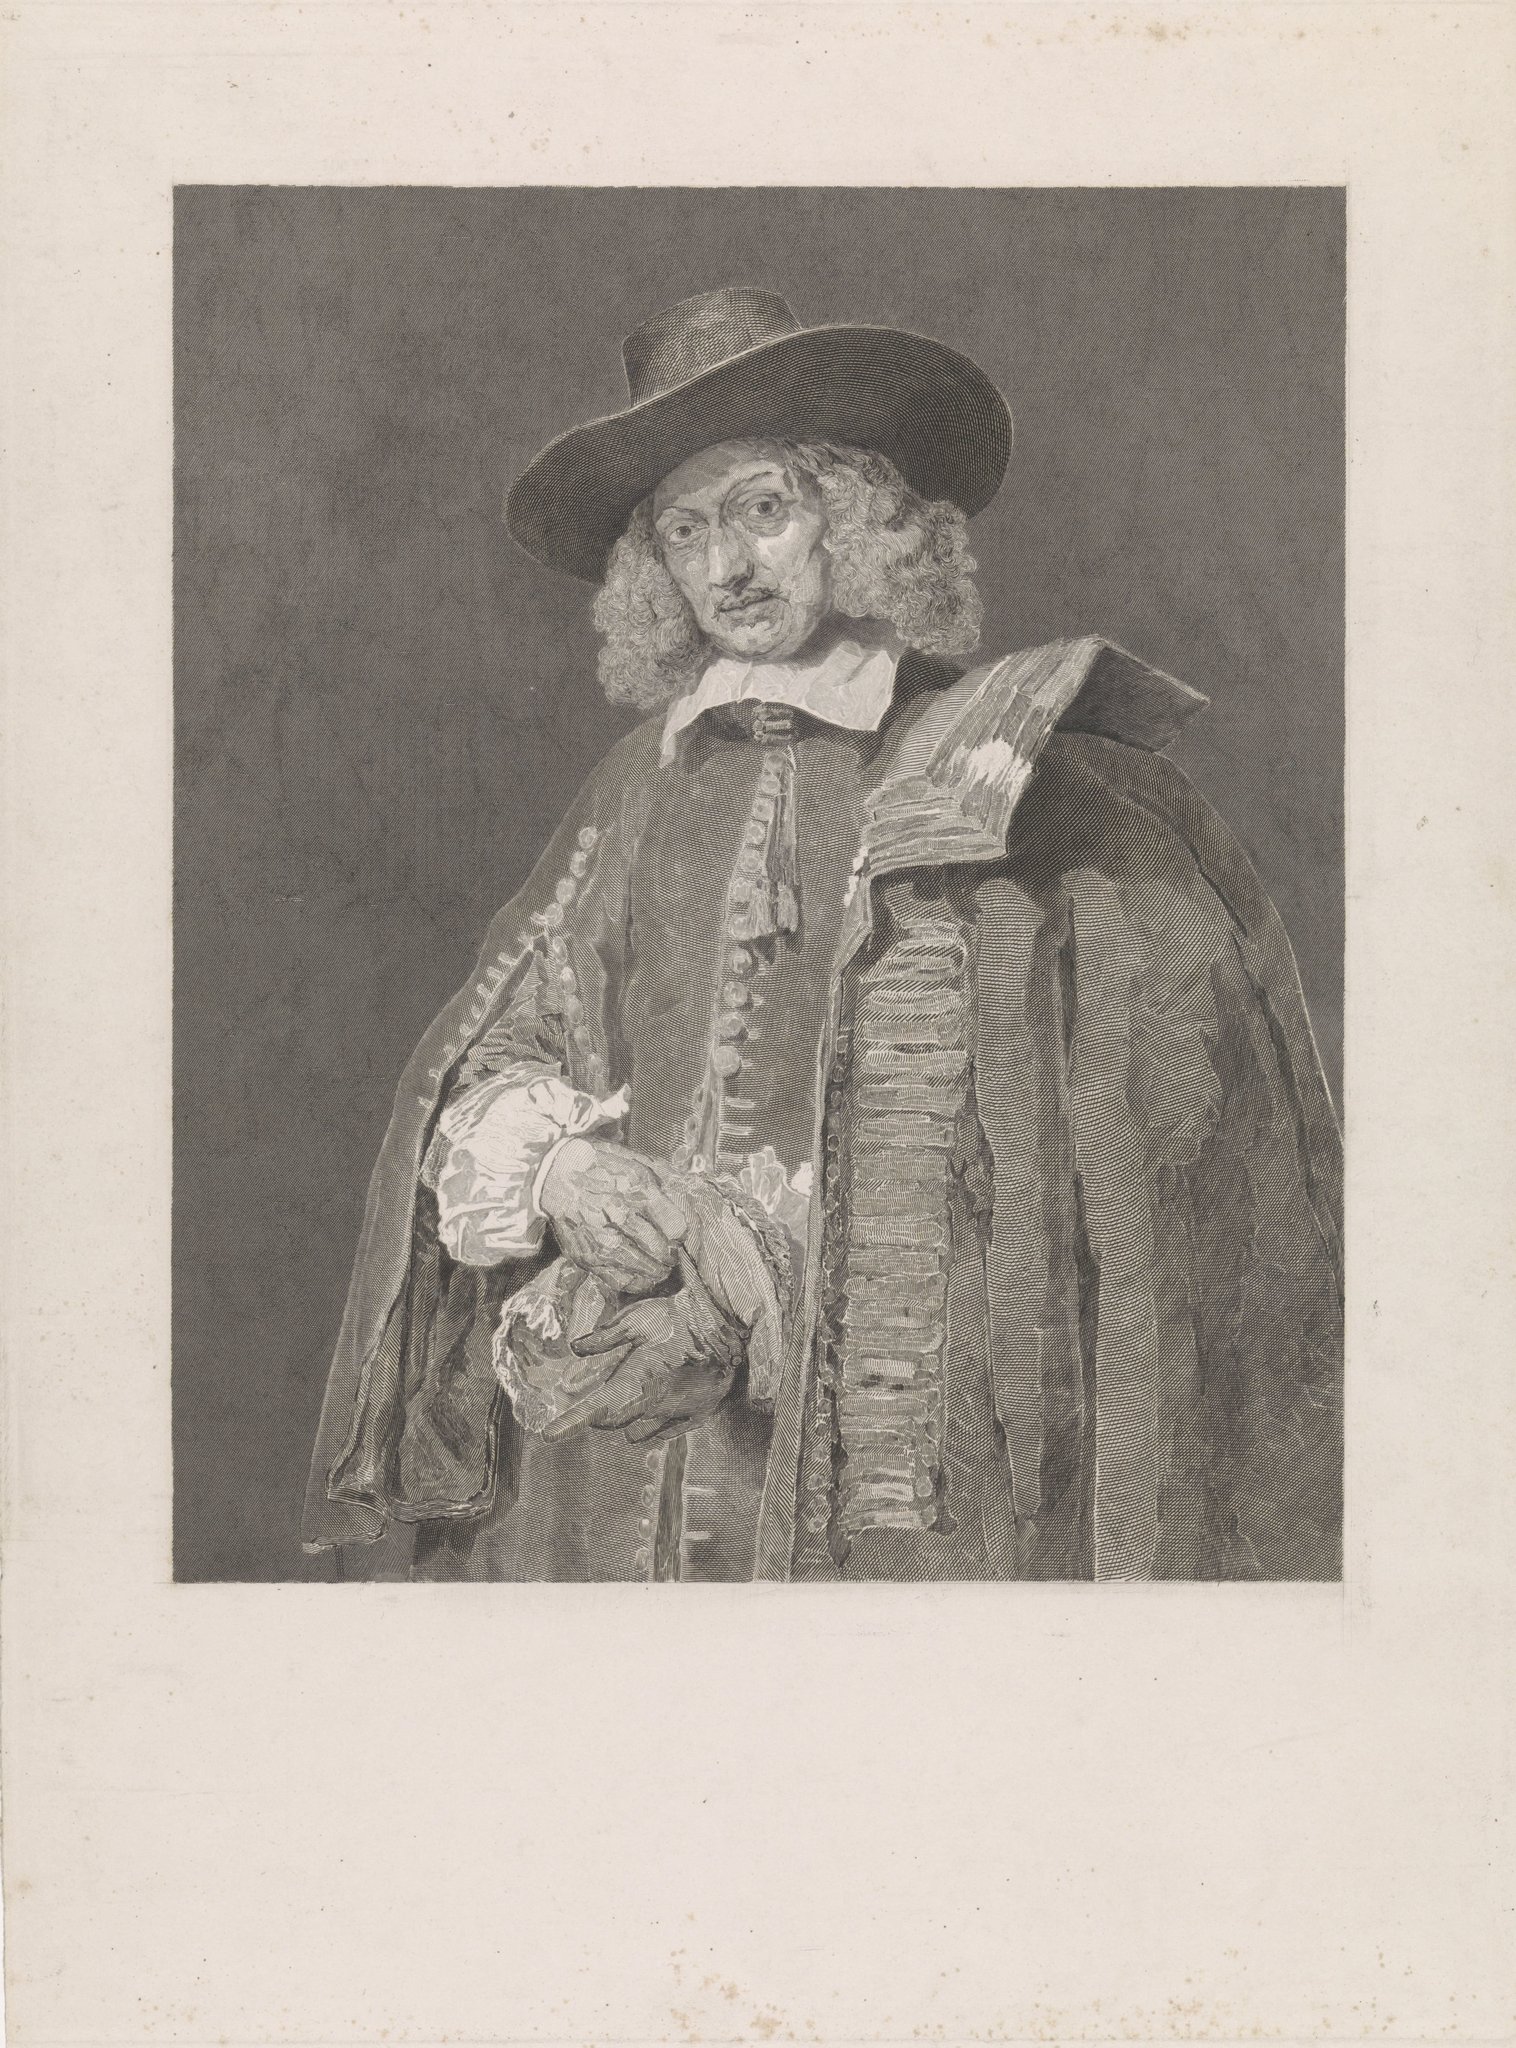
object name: print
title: Portret van Jan Six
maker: johann wilhelm kaiser (i)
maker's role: draughtsman, print maker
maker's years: 1813-1900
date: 1823-1853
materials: paper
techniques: etching, roulette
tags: amsterdam, mayor, jan six (1618-1700)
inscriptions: collector's mark: Lugt 2228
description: Portret ten halven lijve van Jan Six, burgemeester van Amsterdam.